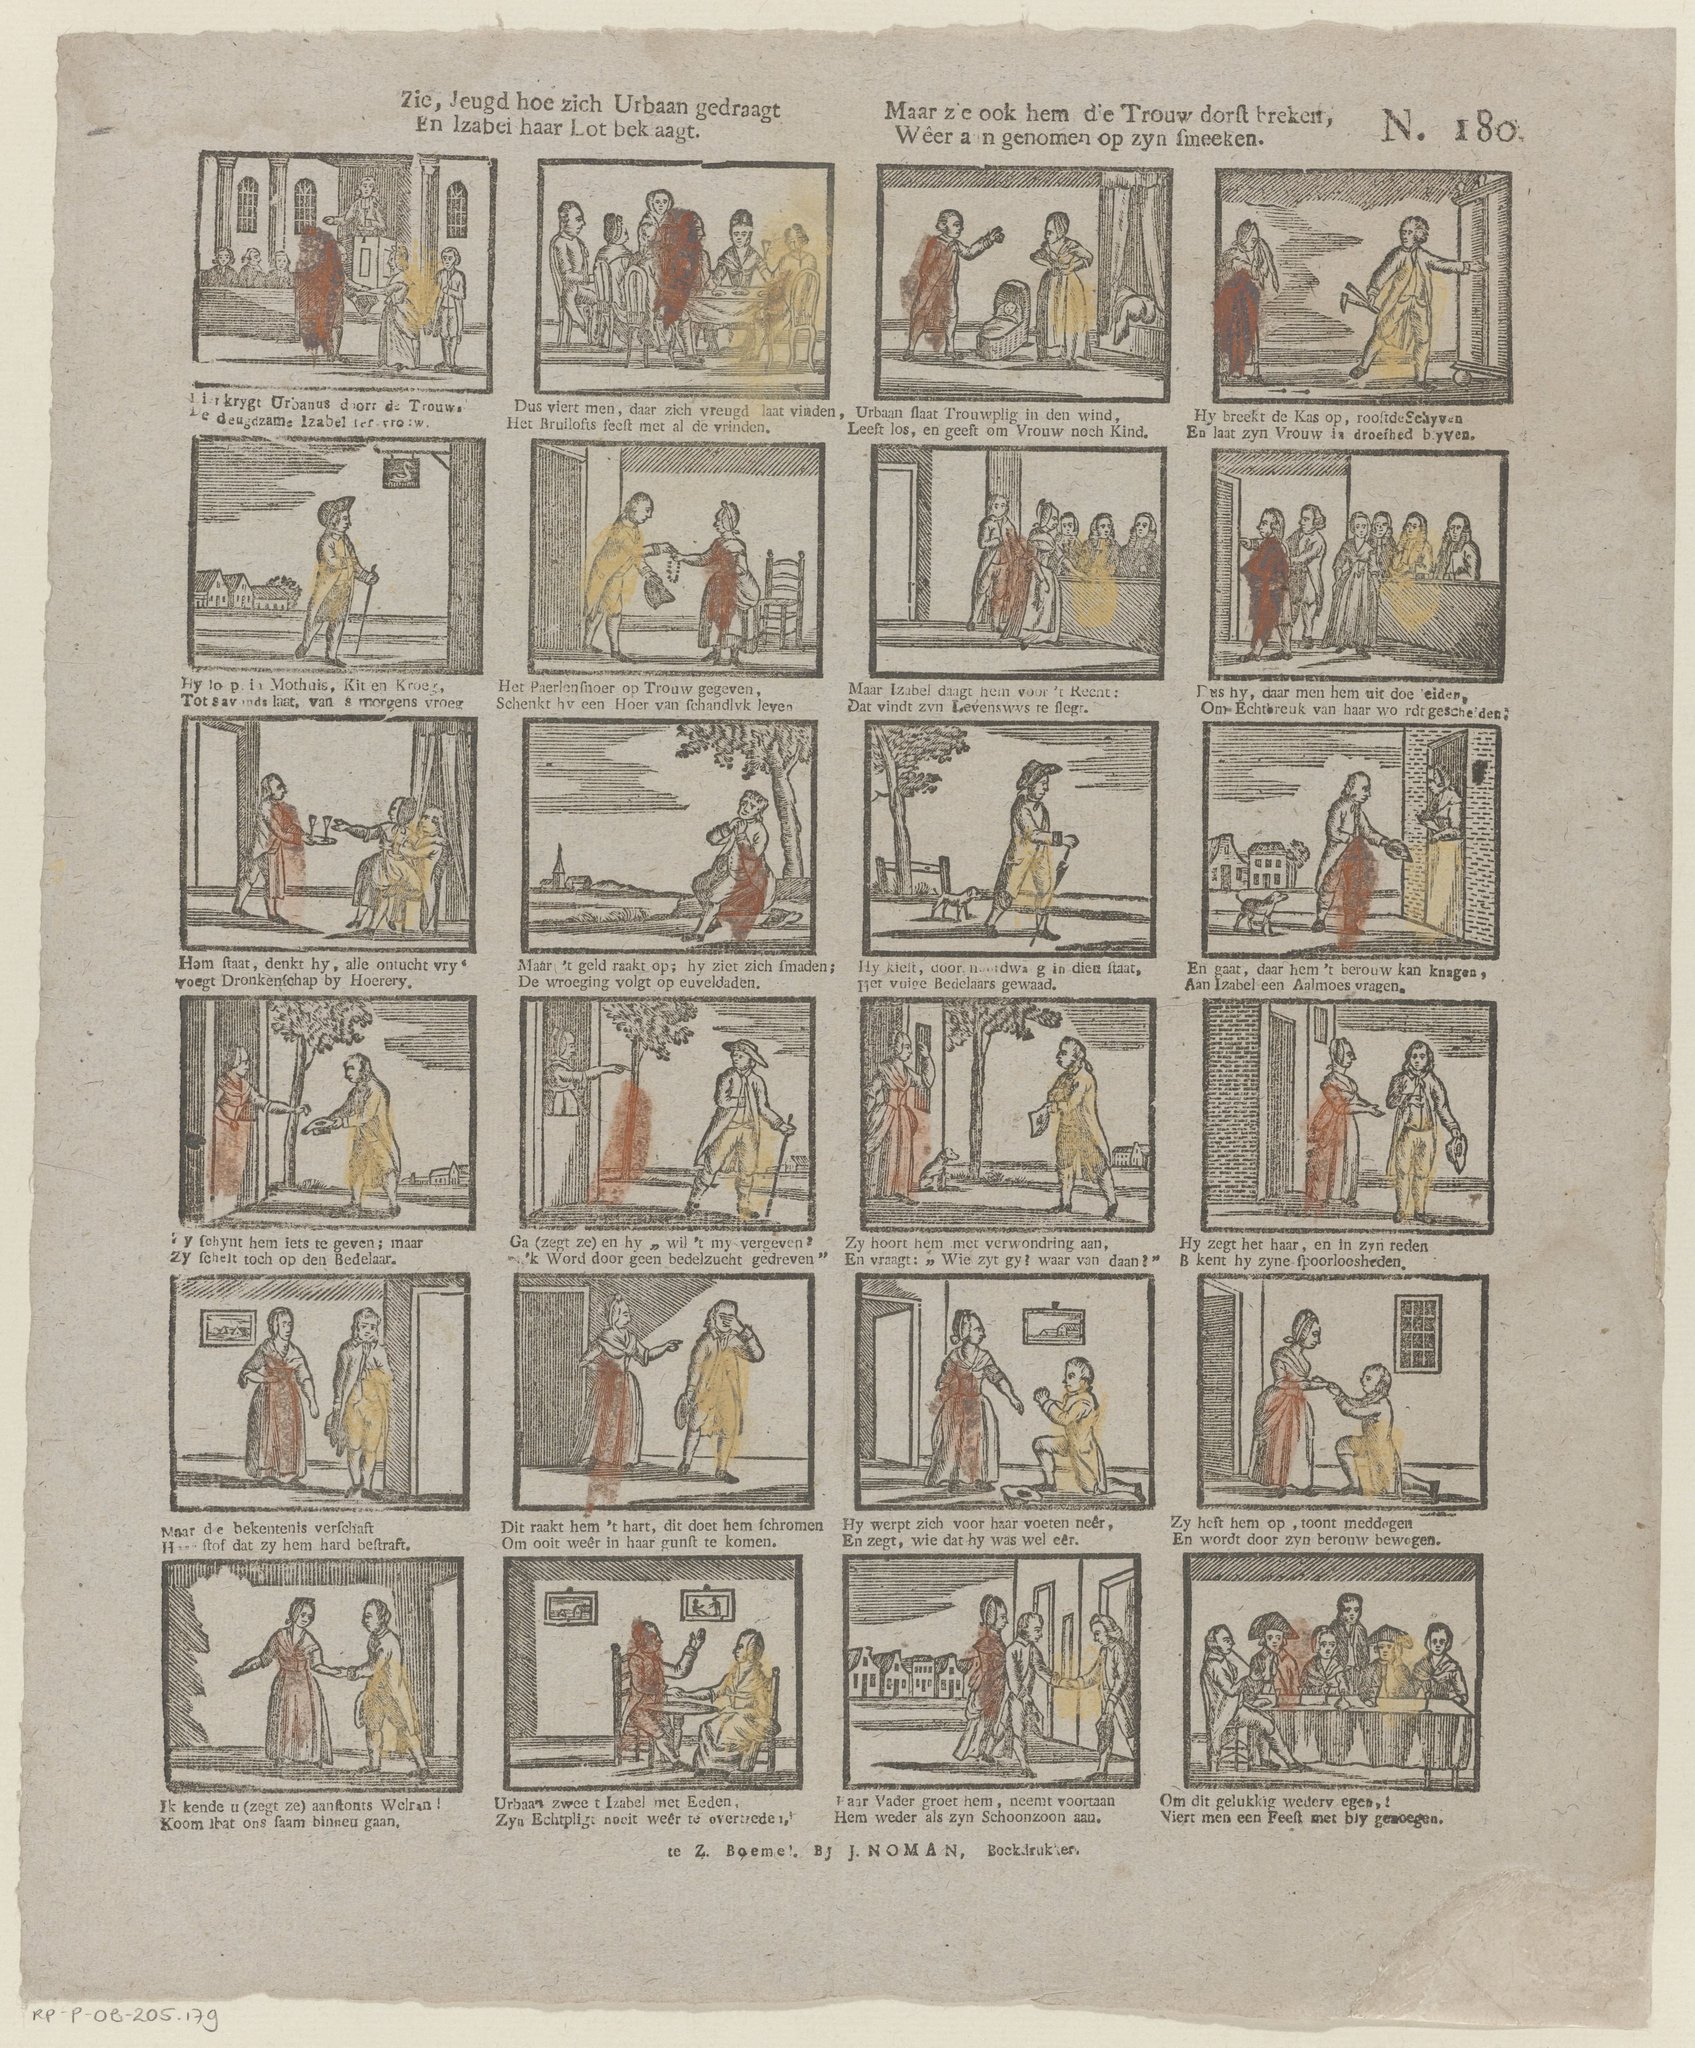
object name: print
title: Zie, jeugd hoe zich Urbaan gedraagt / En Izabel haar lot beklaagt. / Maar zie ook hem die trouw dorst breken, / Weêr aangenomen op zyn smeeken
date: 1806-1830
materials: paper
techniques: colour, letterpress printing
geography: netherlands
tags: bad husband, tales and fairy tales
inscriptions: collector's mark: Lugt 2760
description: Blad met 24 voorstellingen uit het verhaal van Urbaan (Urbanus) en Isabel. Urbaan verzaakt zijn echtplicht en verlaat zijn vrouw en spendeert al hun geld in de herberg, in de bedelstaf geraakt bekent hij zijn schuld en wordt door Isabel weer in genade teruggenomen. Onder elk plaatje een tweeregelig vers. Genummerd rechtsboven: No. 180.